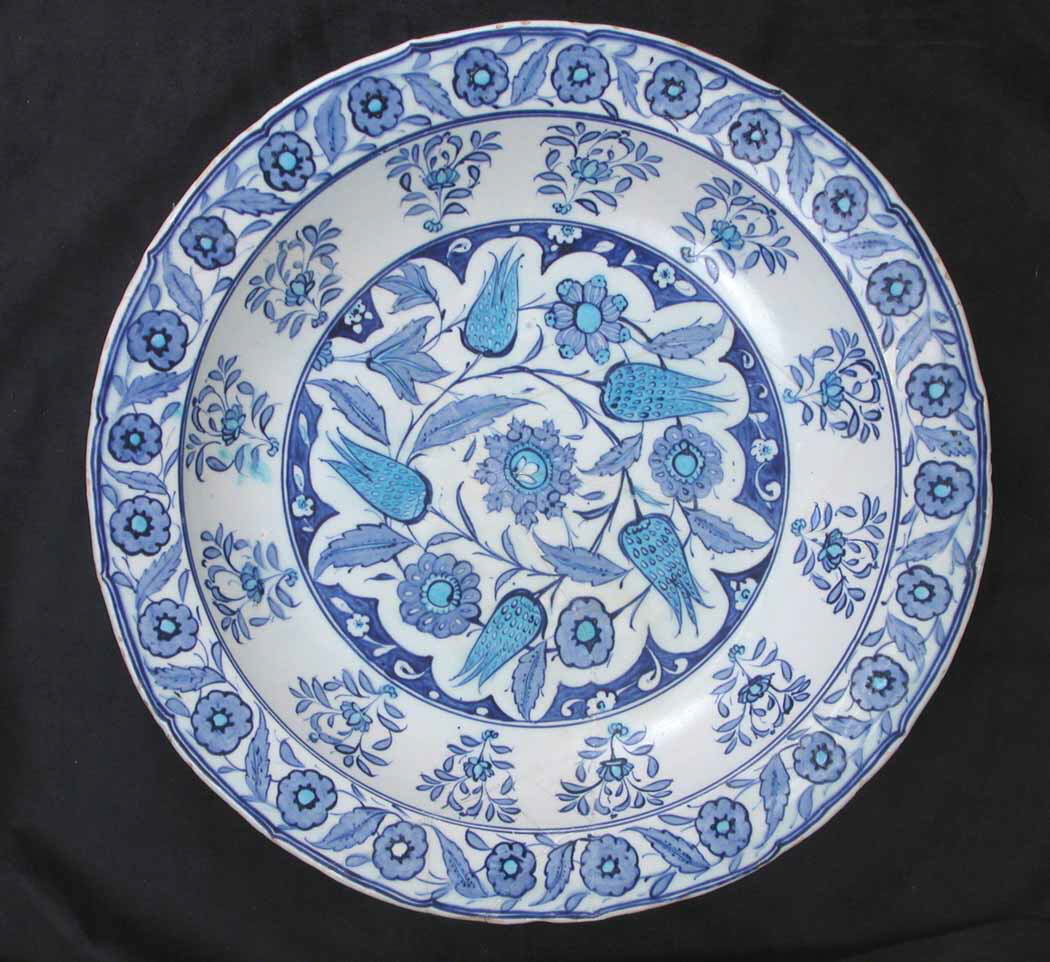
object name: bowl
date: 1534-1566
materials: stonepaste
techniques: glazing, painting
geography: turkey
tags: flowers